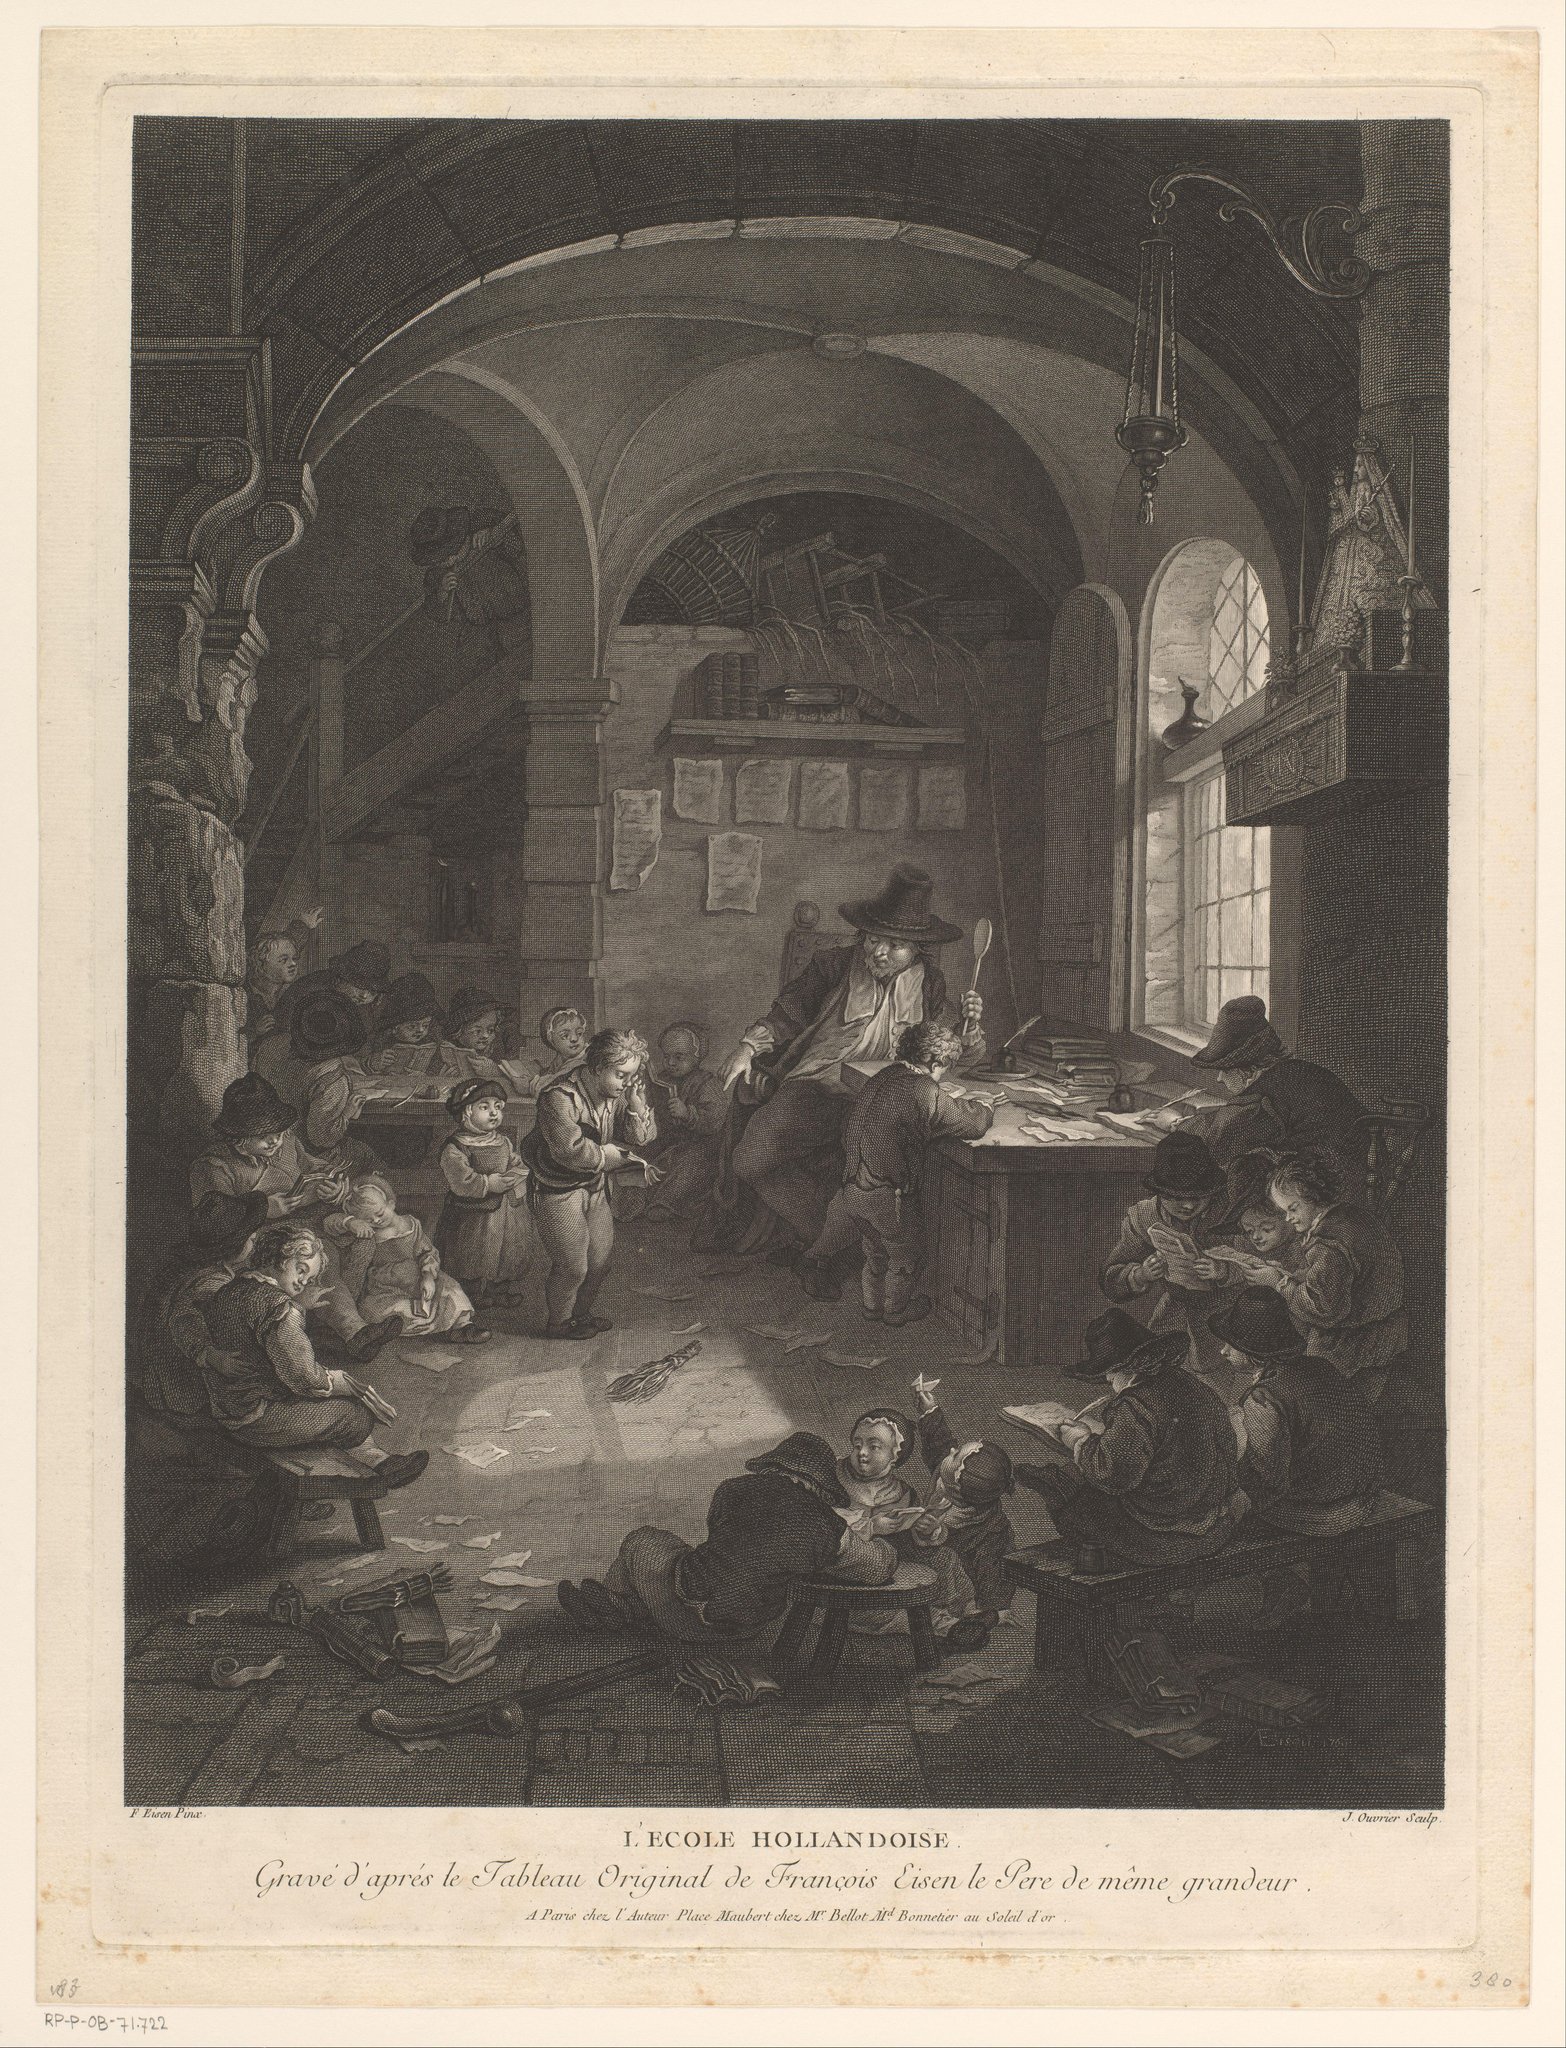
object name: print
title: Leslokaal met onderwijzer die leerling bestraft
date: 1735-1784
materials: paper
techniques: engraving, etching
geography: paris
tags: punishment at school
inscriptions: collector's mark: Lugt 2228